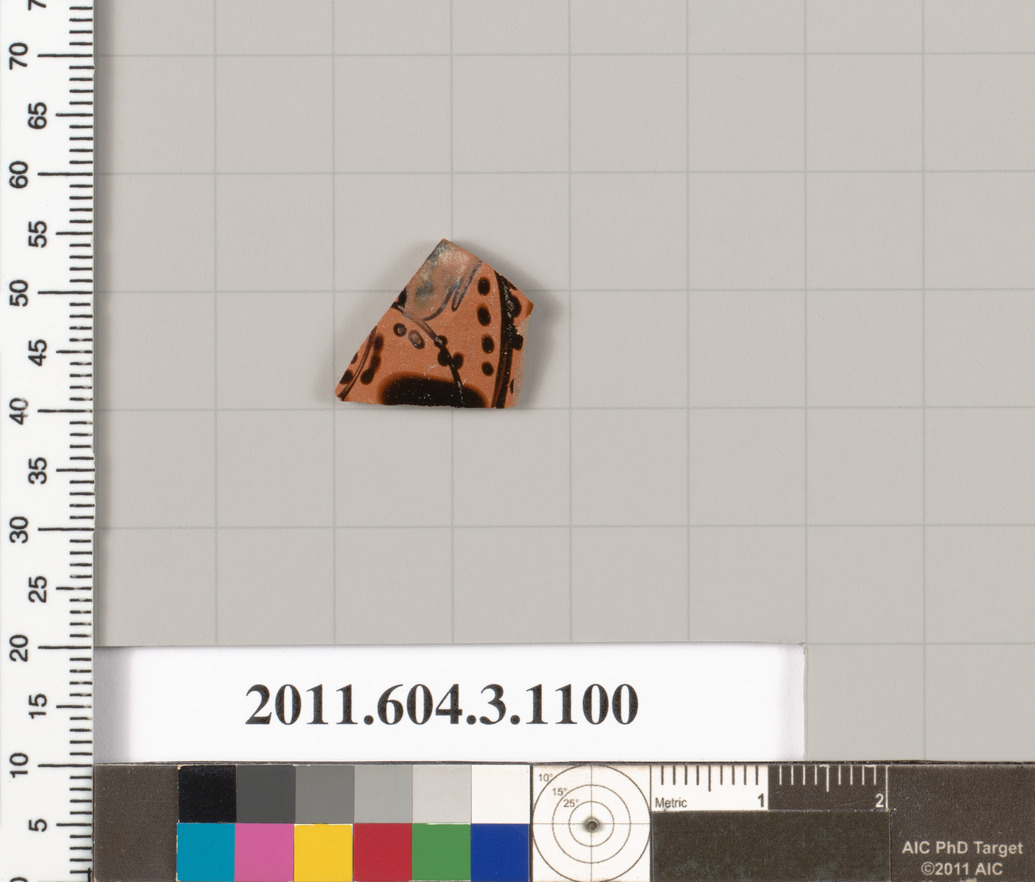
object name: mastoid or kyathos fragment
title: Terracotta fragment of a mastoid (drinking cup with narrow base) or a kyathos (cup-shaped ladle)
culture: greek, attic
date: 534-468 BCE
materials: terracotta